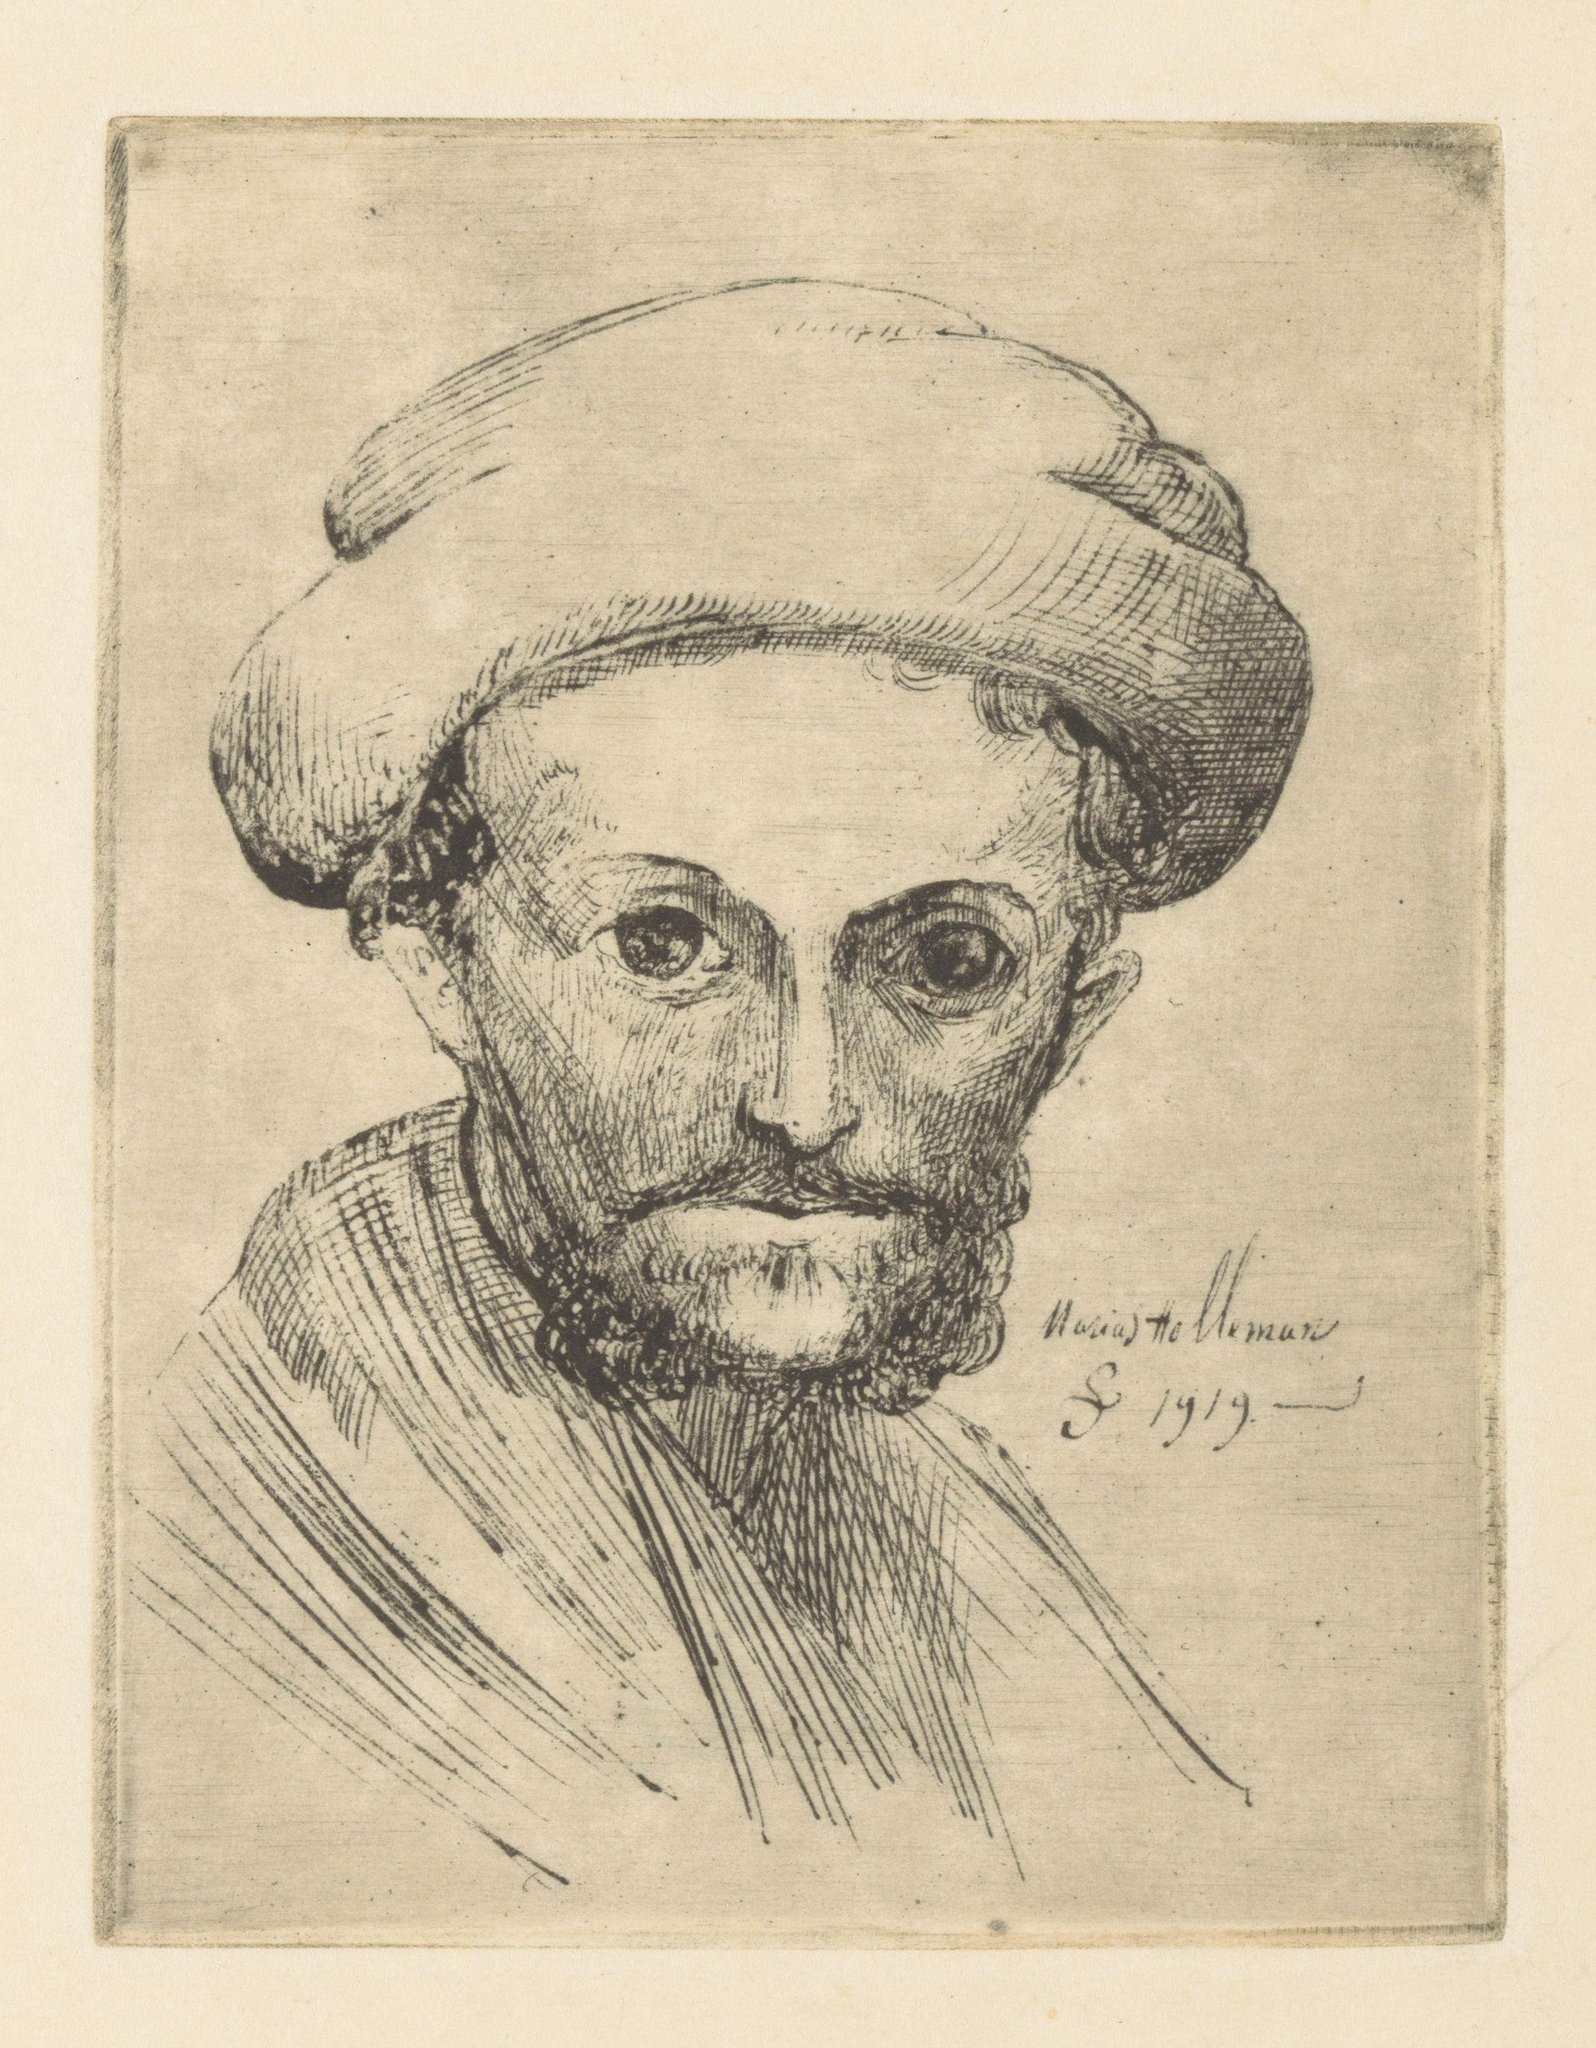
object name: print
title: Oude man met baard en muts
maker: marius holleman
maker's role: draughtsman, print maker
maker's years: 1878-1926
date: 1919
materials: paper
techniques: etching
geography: groningen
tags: old man, head-gear: hat, beard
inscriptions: collector's mark: Lugt 2228